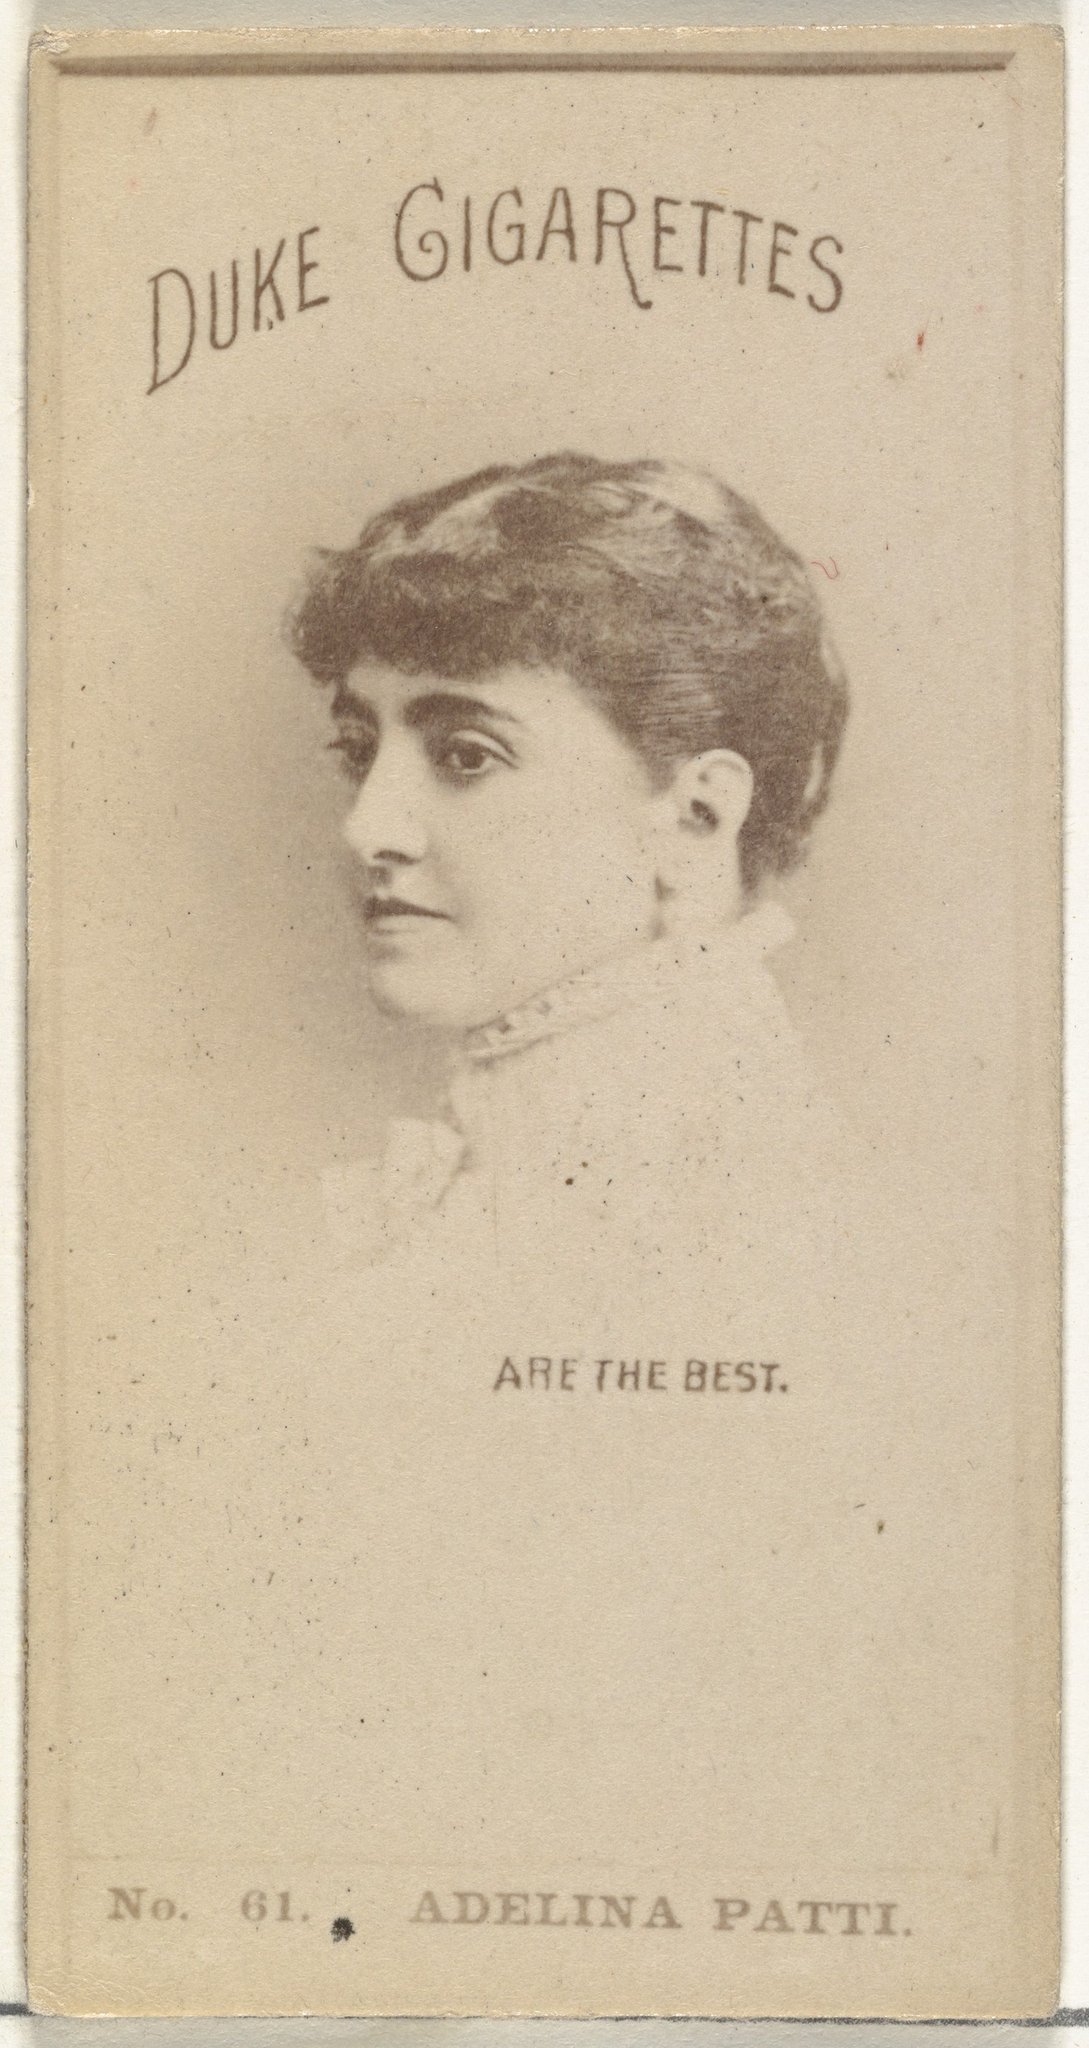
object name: photograph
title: Card Number 61, Adina Patti, from the Actors and Actresses series (N145-6) issued by Duke Sons & Co. to promote Duke Cigarettes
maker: w. duke, sons & co.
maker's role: publisher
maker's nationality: american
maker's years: 1870-1920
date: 1880-1889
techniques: albumen silver print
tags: portraits,women,actresses